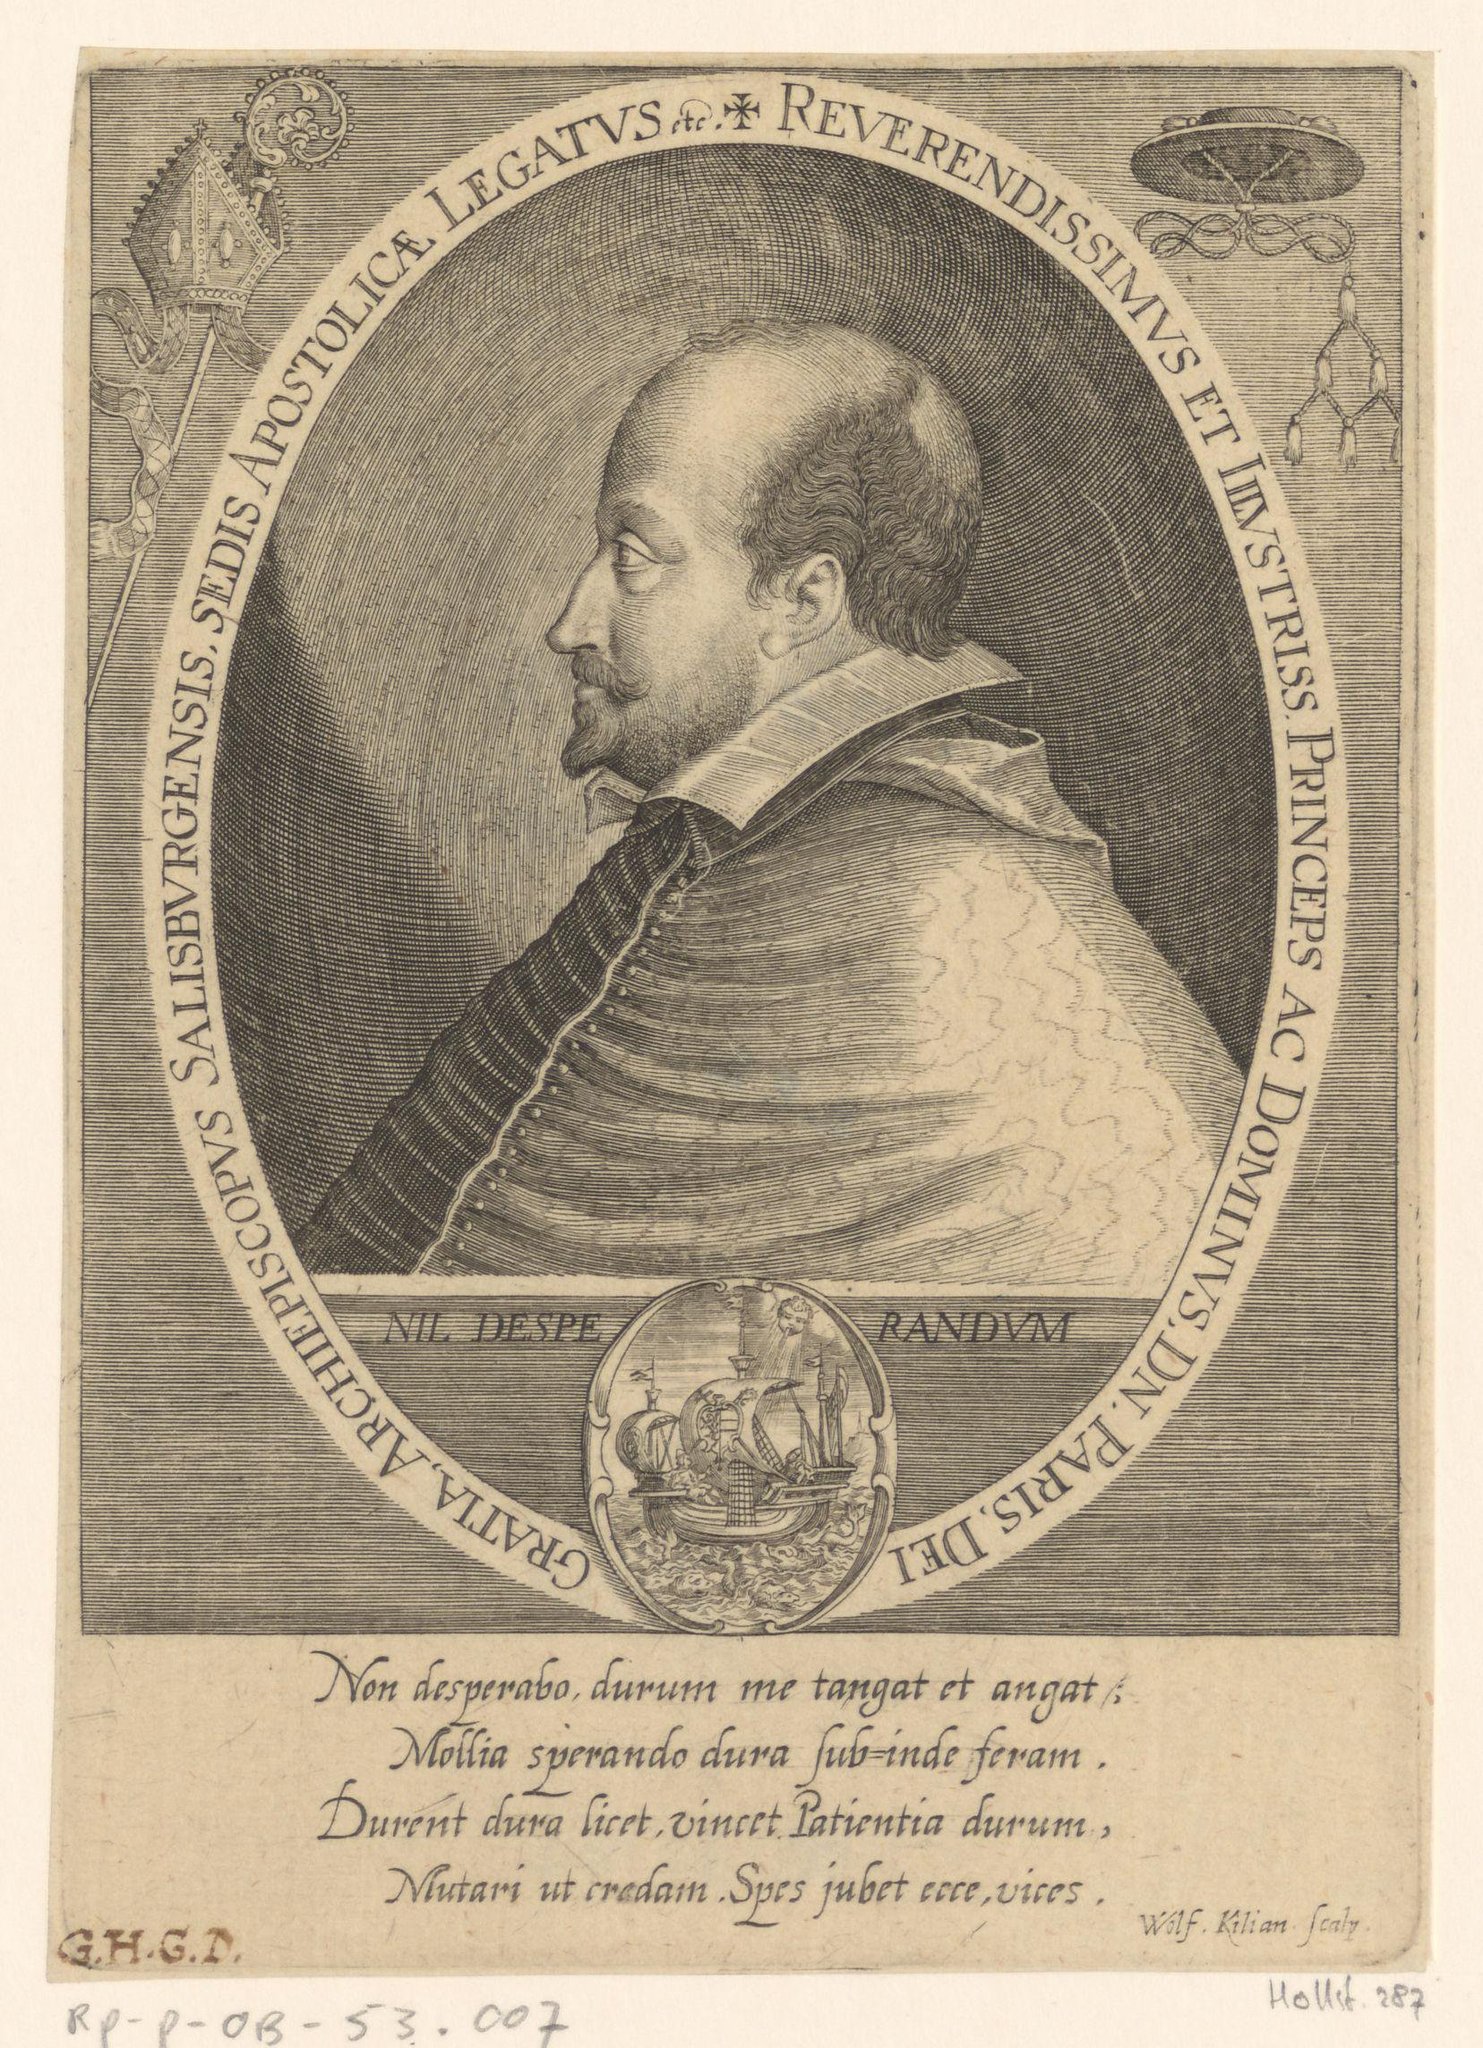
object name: print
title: Portret van Paris von Salzburg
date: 1606-1662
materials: paper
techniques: engraving, etching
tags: cardinal, historical persons, insignia of cardinal, e.g. hat, mantle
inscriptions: annotation: ‘G.H.G.I.’, collector's mark: Lugt 2233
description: Tekst in het Latijn in de omlijsting en in de ondermarge.